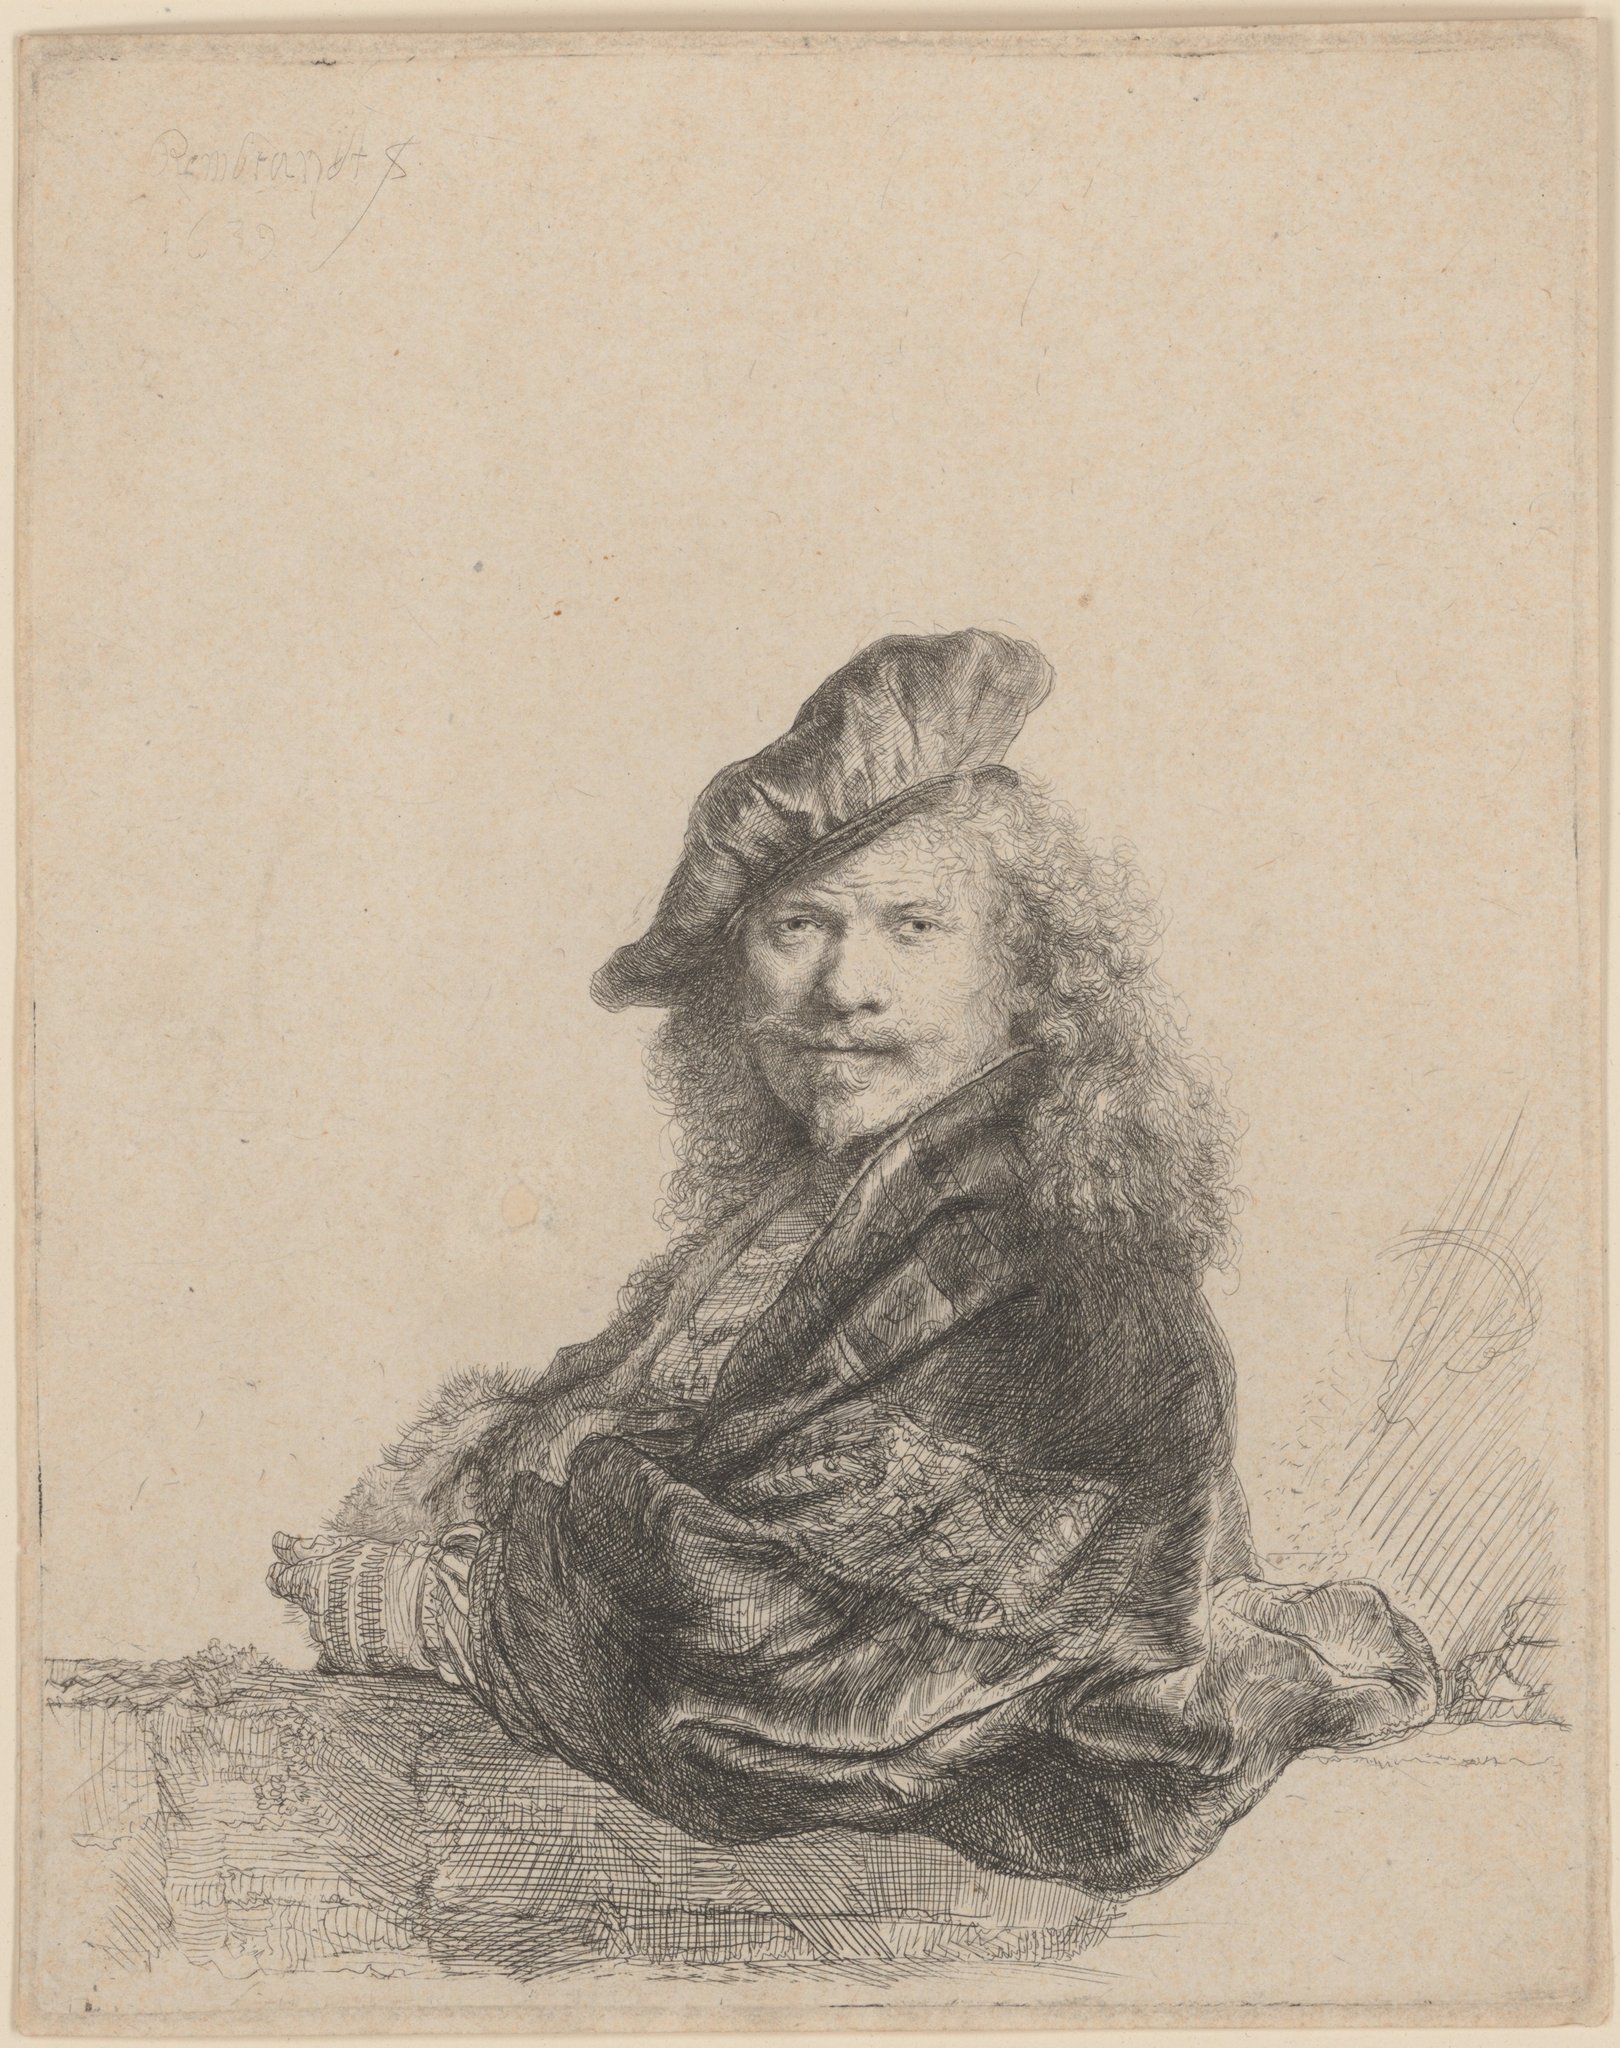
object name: print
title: Self-Portrait Leaning on a Stone Sill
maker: rembrandt van rijn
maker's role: artist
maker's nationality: dutch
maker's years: 1606-1669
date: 1639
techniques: engraving, drypoint, etching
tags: men,self-portraits